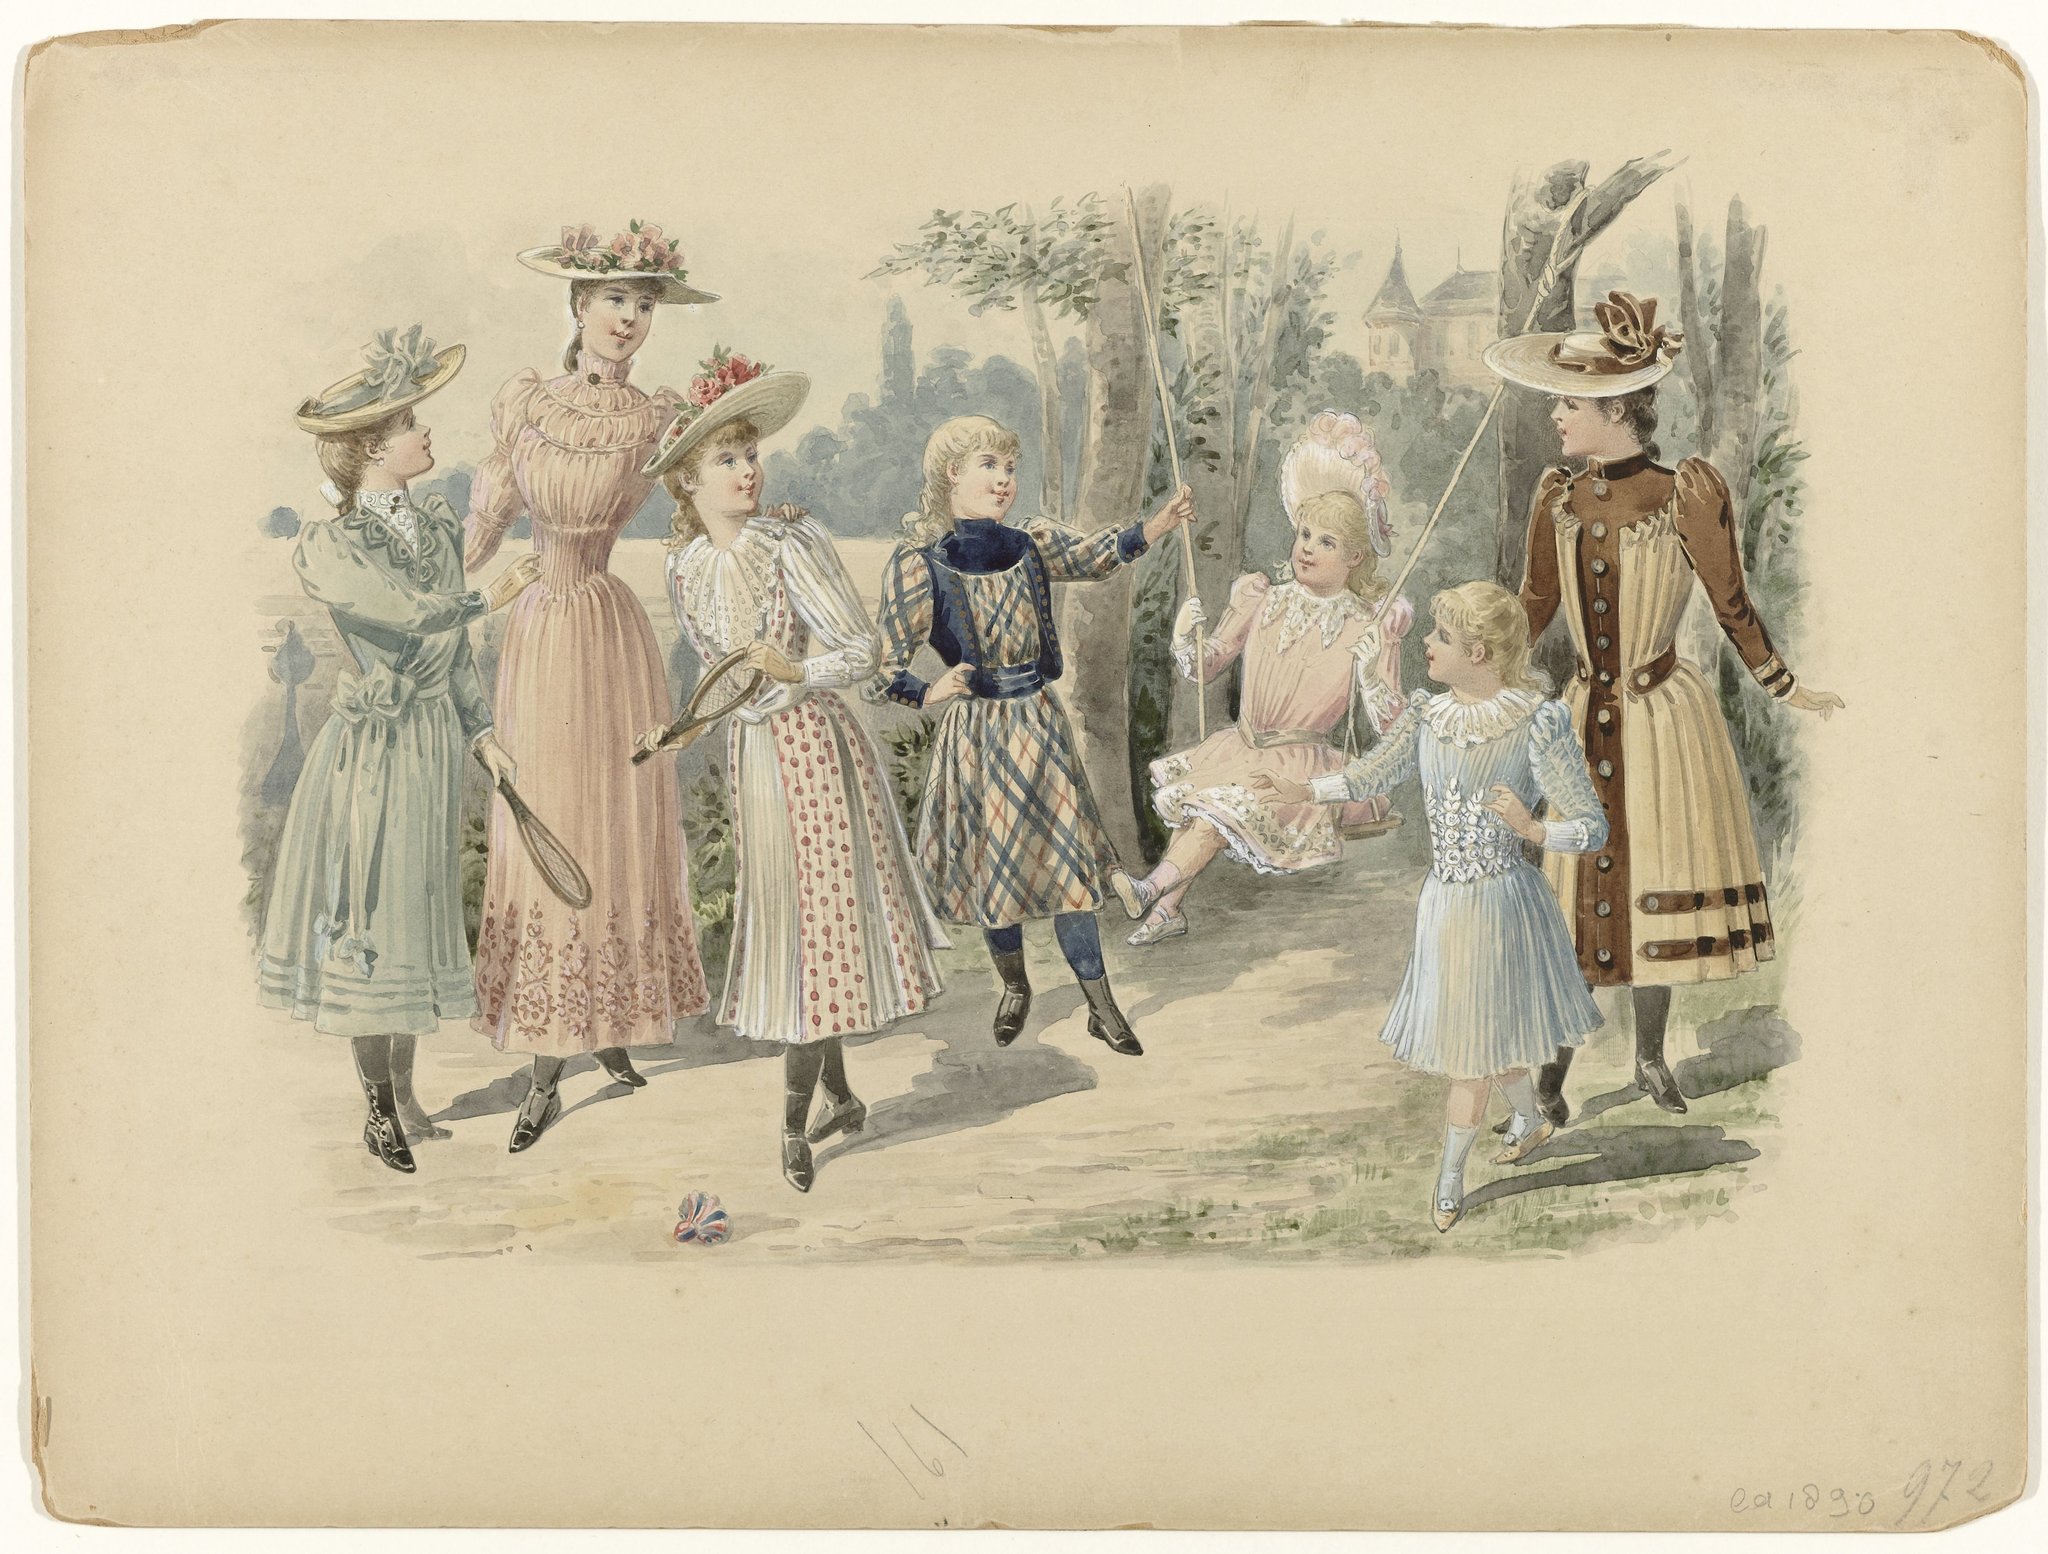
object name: watercolor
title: Kinderkleding 1890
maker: lefranco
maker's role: draughtsman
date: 1890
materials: paper, pencil, watercolor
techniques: brush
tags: clothes, costume (+ children's clothes), head-gear: hat (+ girls' clothes), fashion plates, dress, gown (+ girls' clothes)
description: Tekening met kinderkleding voor modeprent No. 972 in 'Le Salon de la Mode et du Costume Paris', 1890.